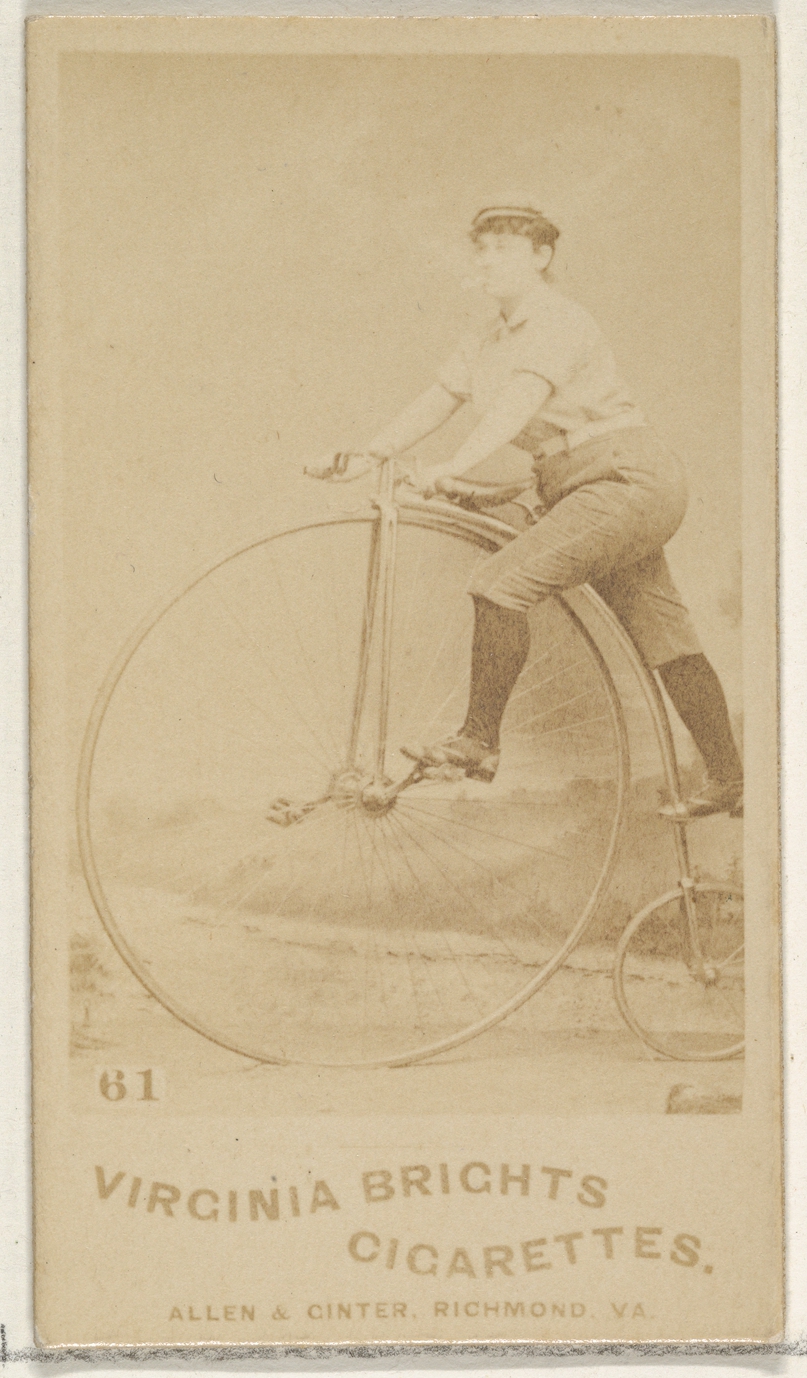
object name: photograph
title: Card 61, from the Girl Cyclists series (N49) for Virginia Brights Cigarettes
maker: allen & ginter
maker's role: publisher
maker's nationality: american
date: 1887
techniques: albumen silver print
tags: women,bicycles